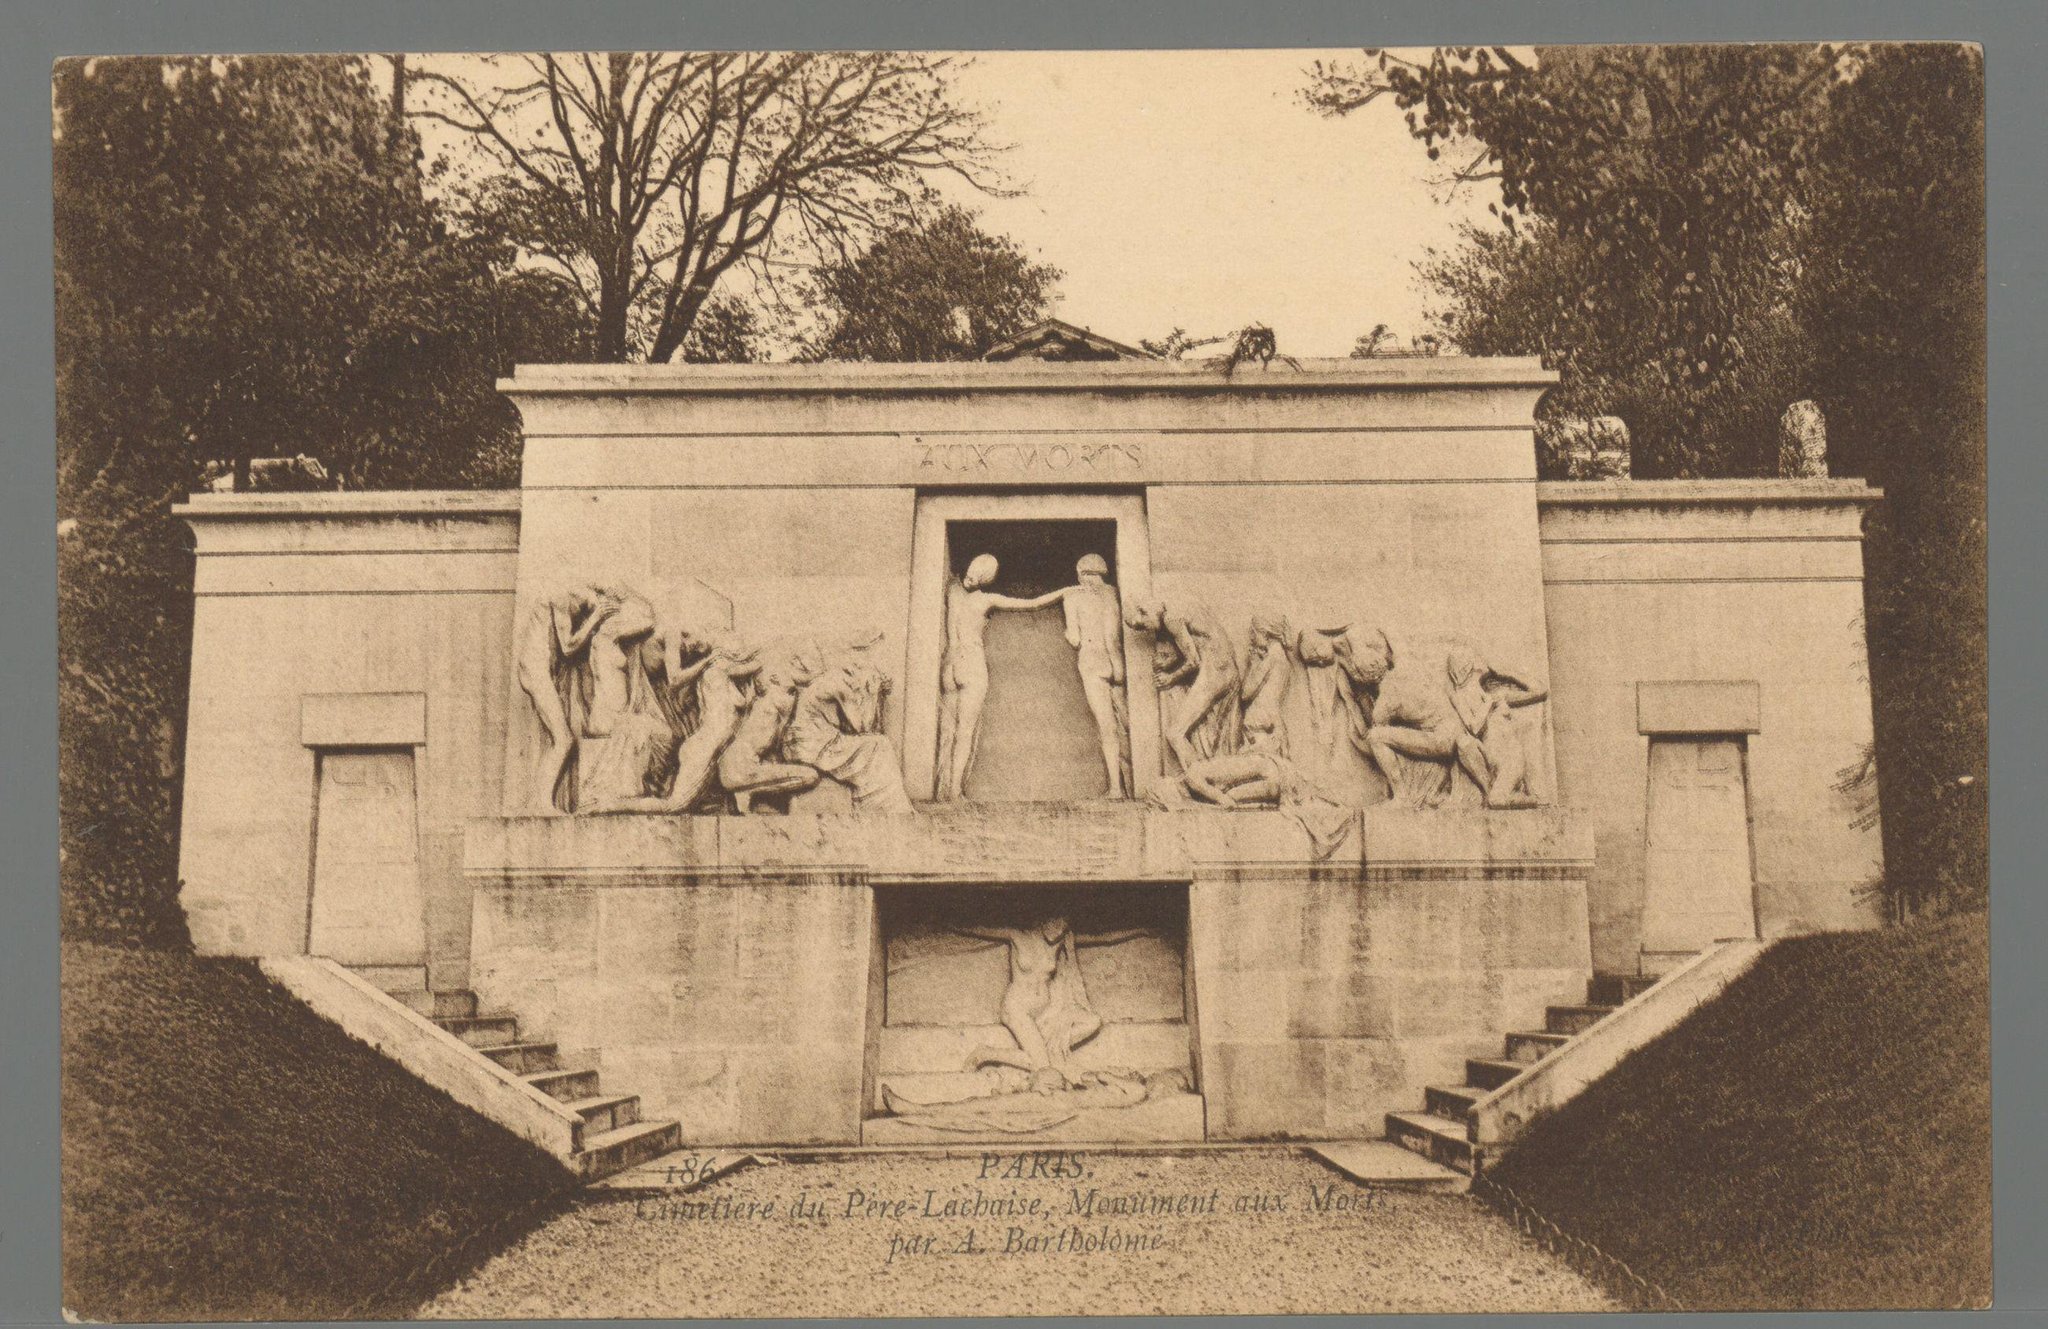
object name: photomechanical print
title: Paris. Cimétière du Père-Lachaise. Monument aux Morts, par A. Bartholomé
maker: Anonymous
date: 1904-1906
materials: cardboard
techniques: photograph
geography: paris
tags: monument, statue, cemetery, park-like burying ground